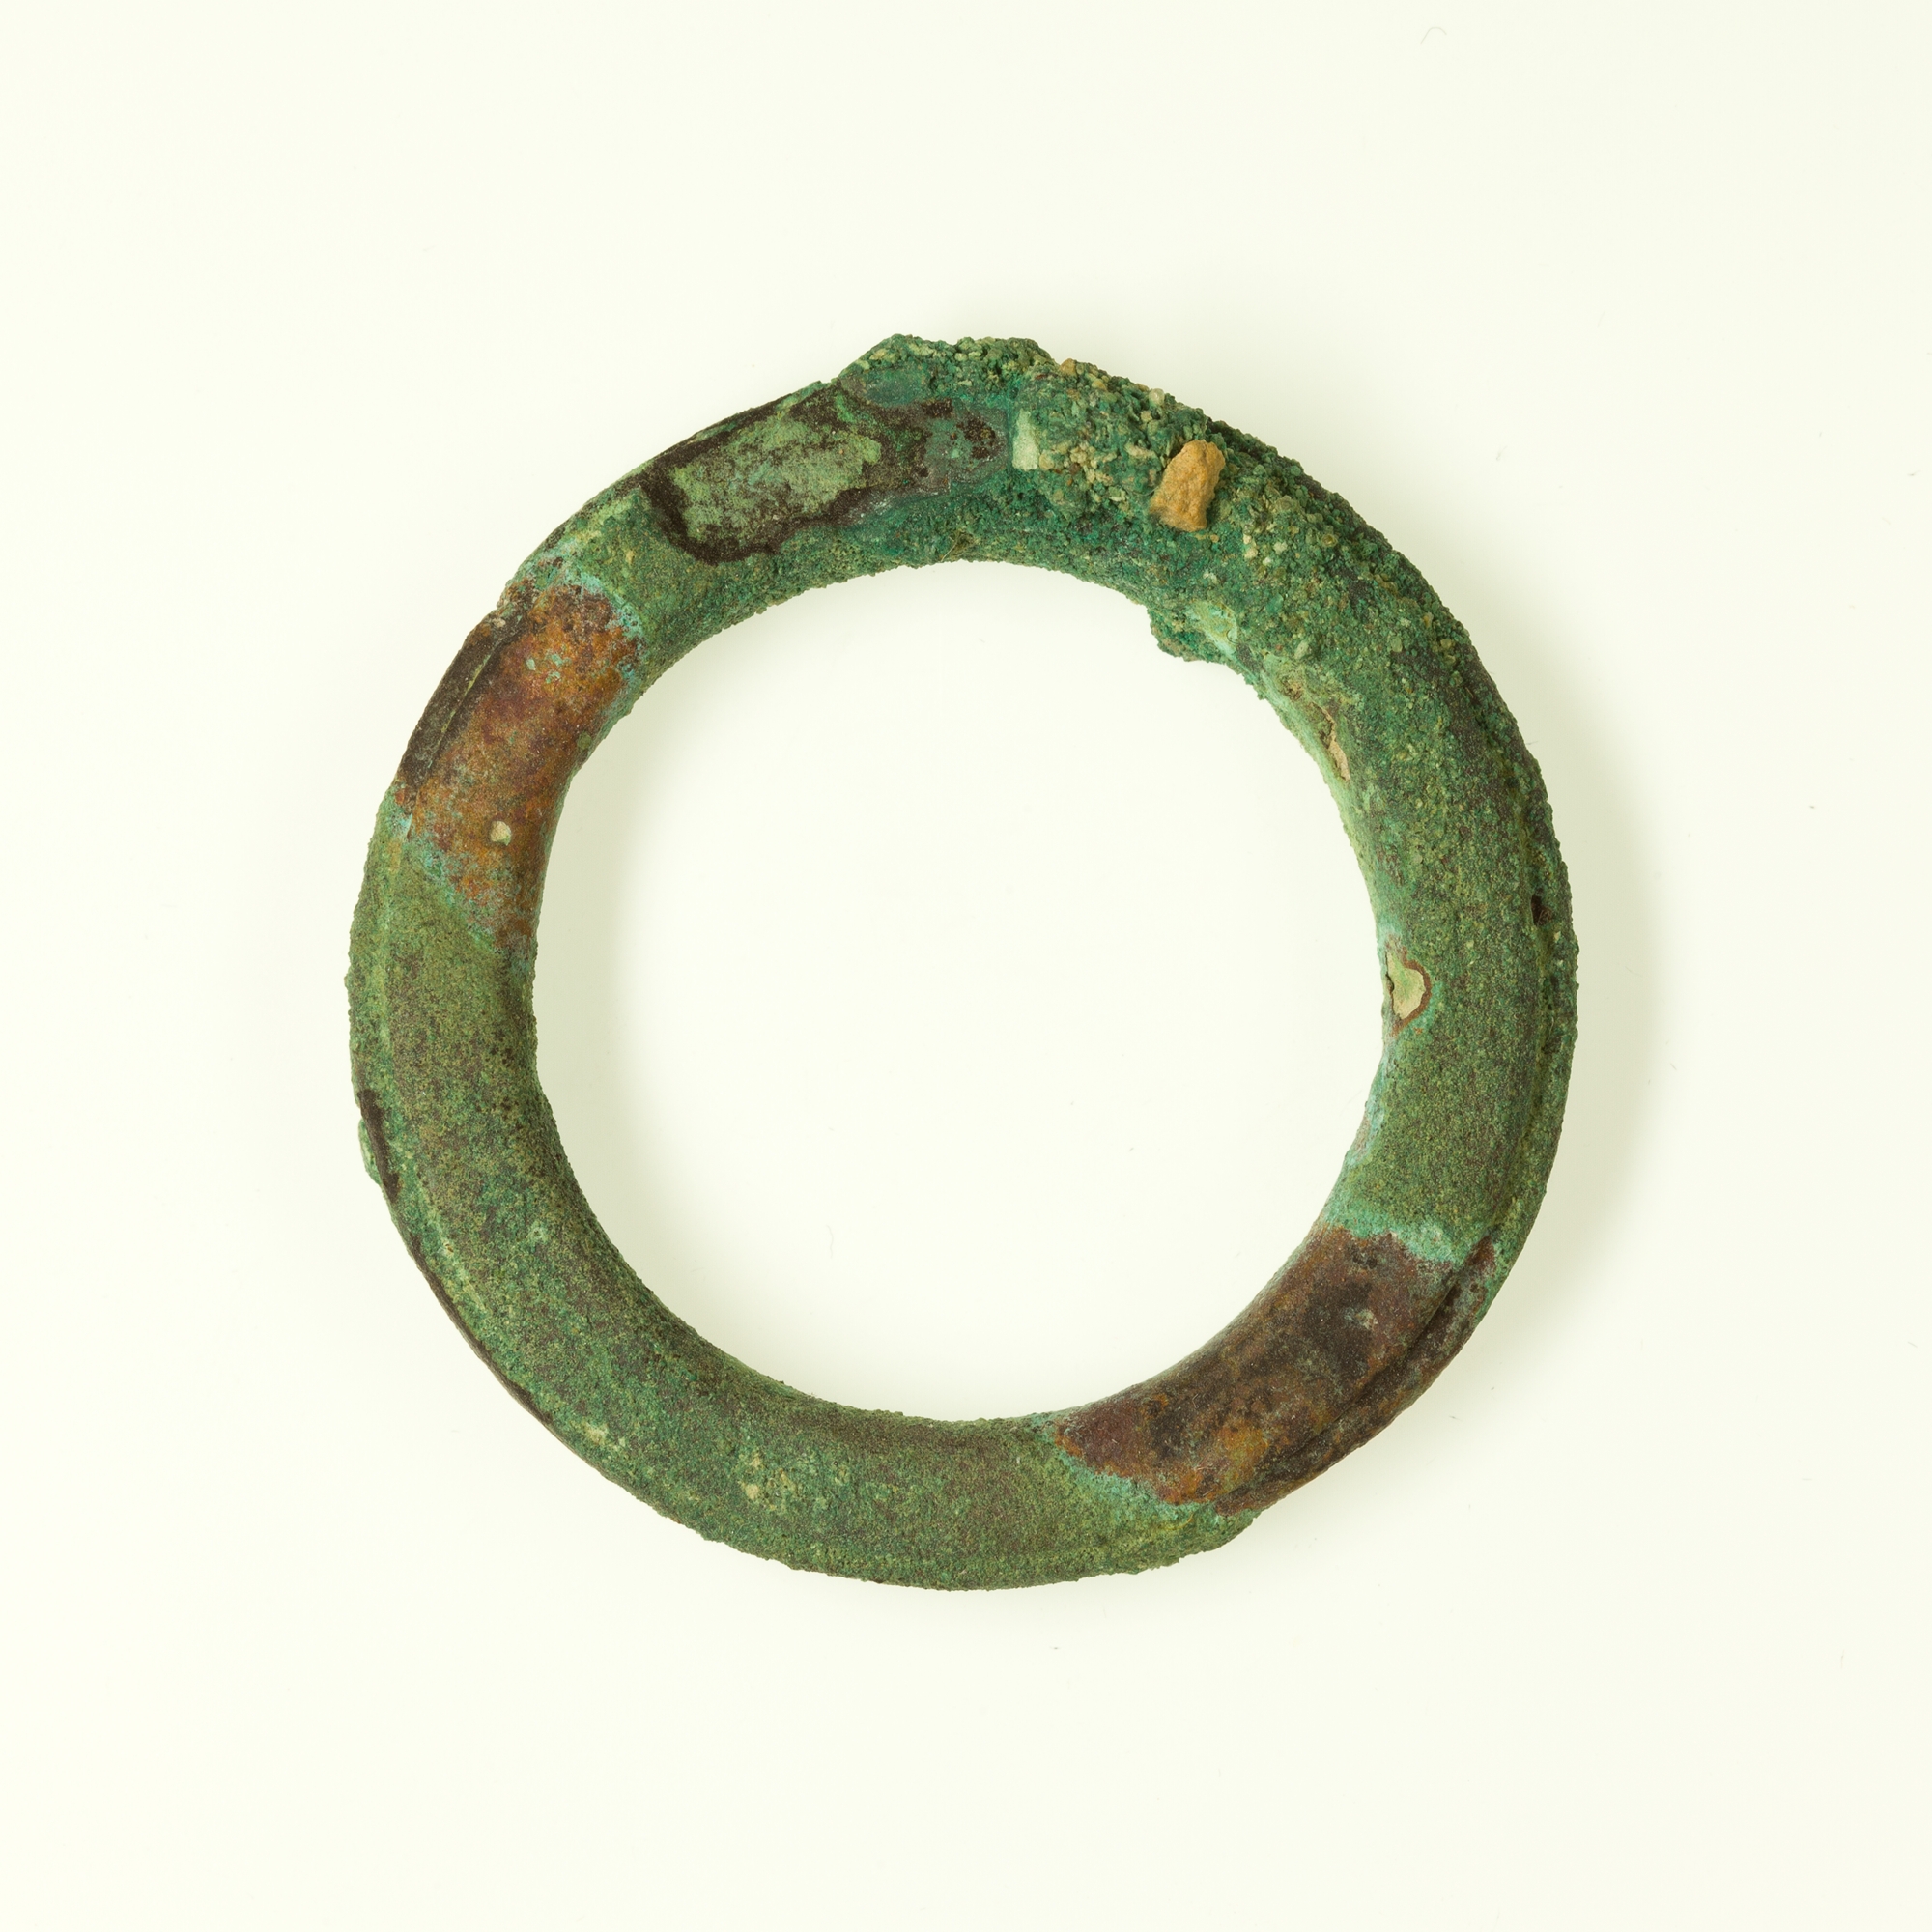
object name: household ring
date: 1295-1070 BCE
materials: bronze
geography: egypt